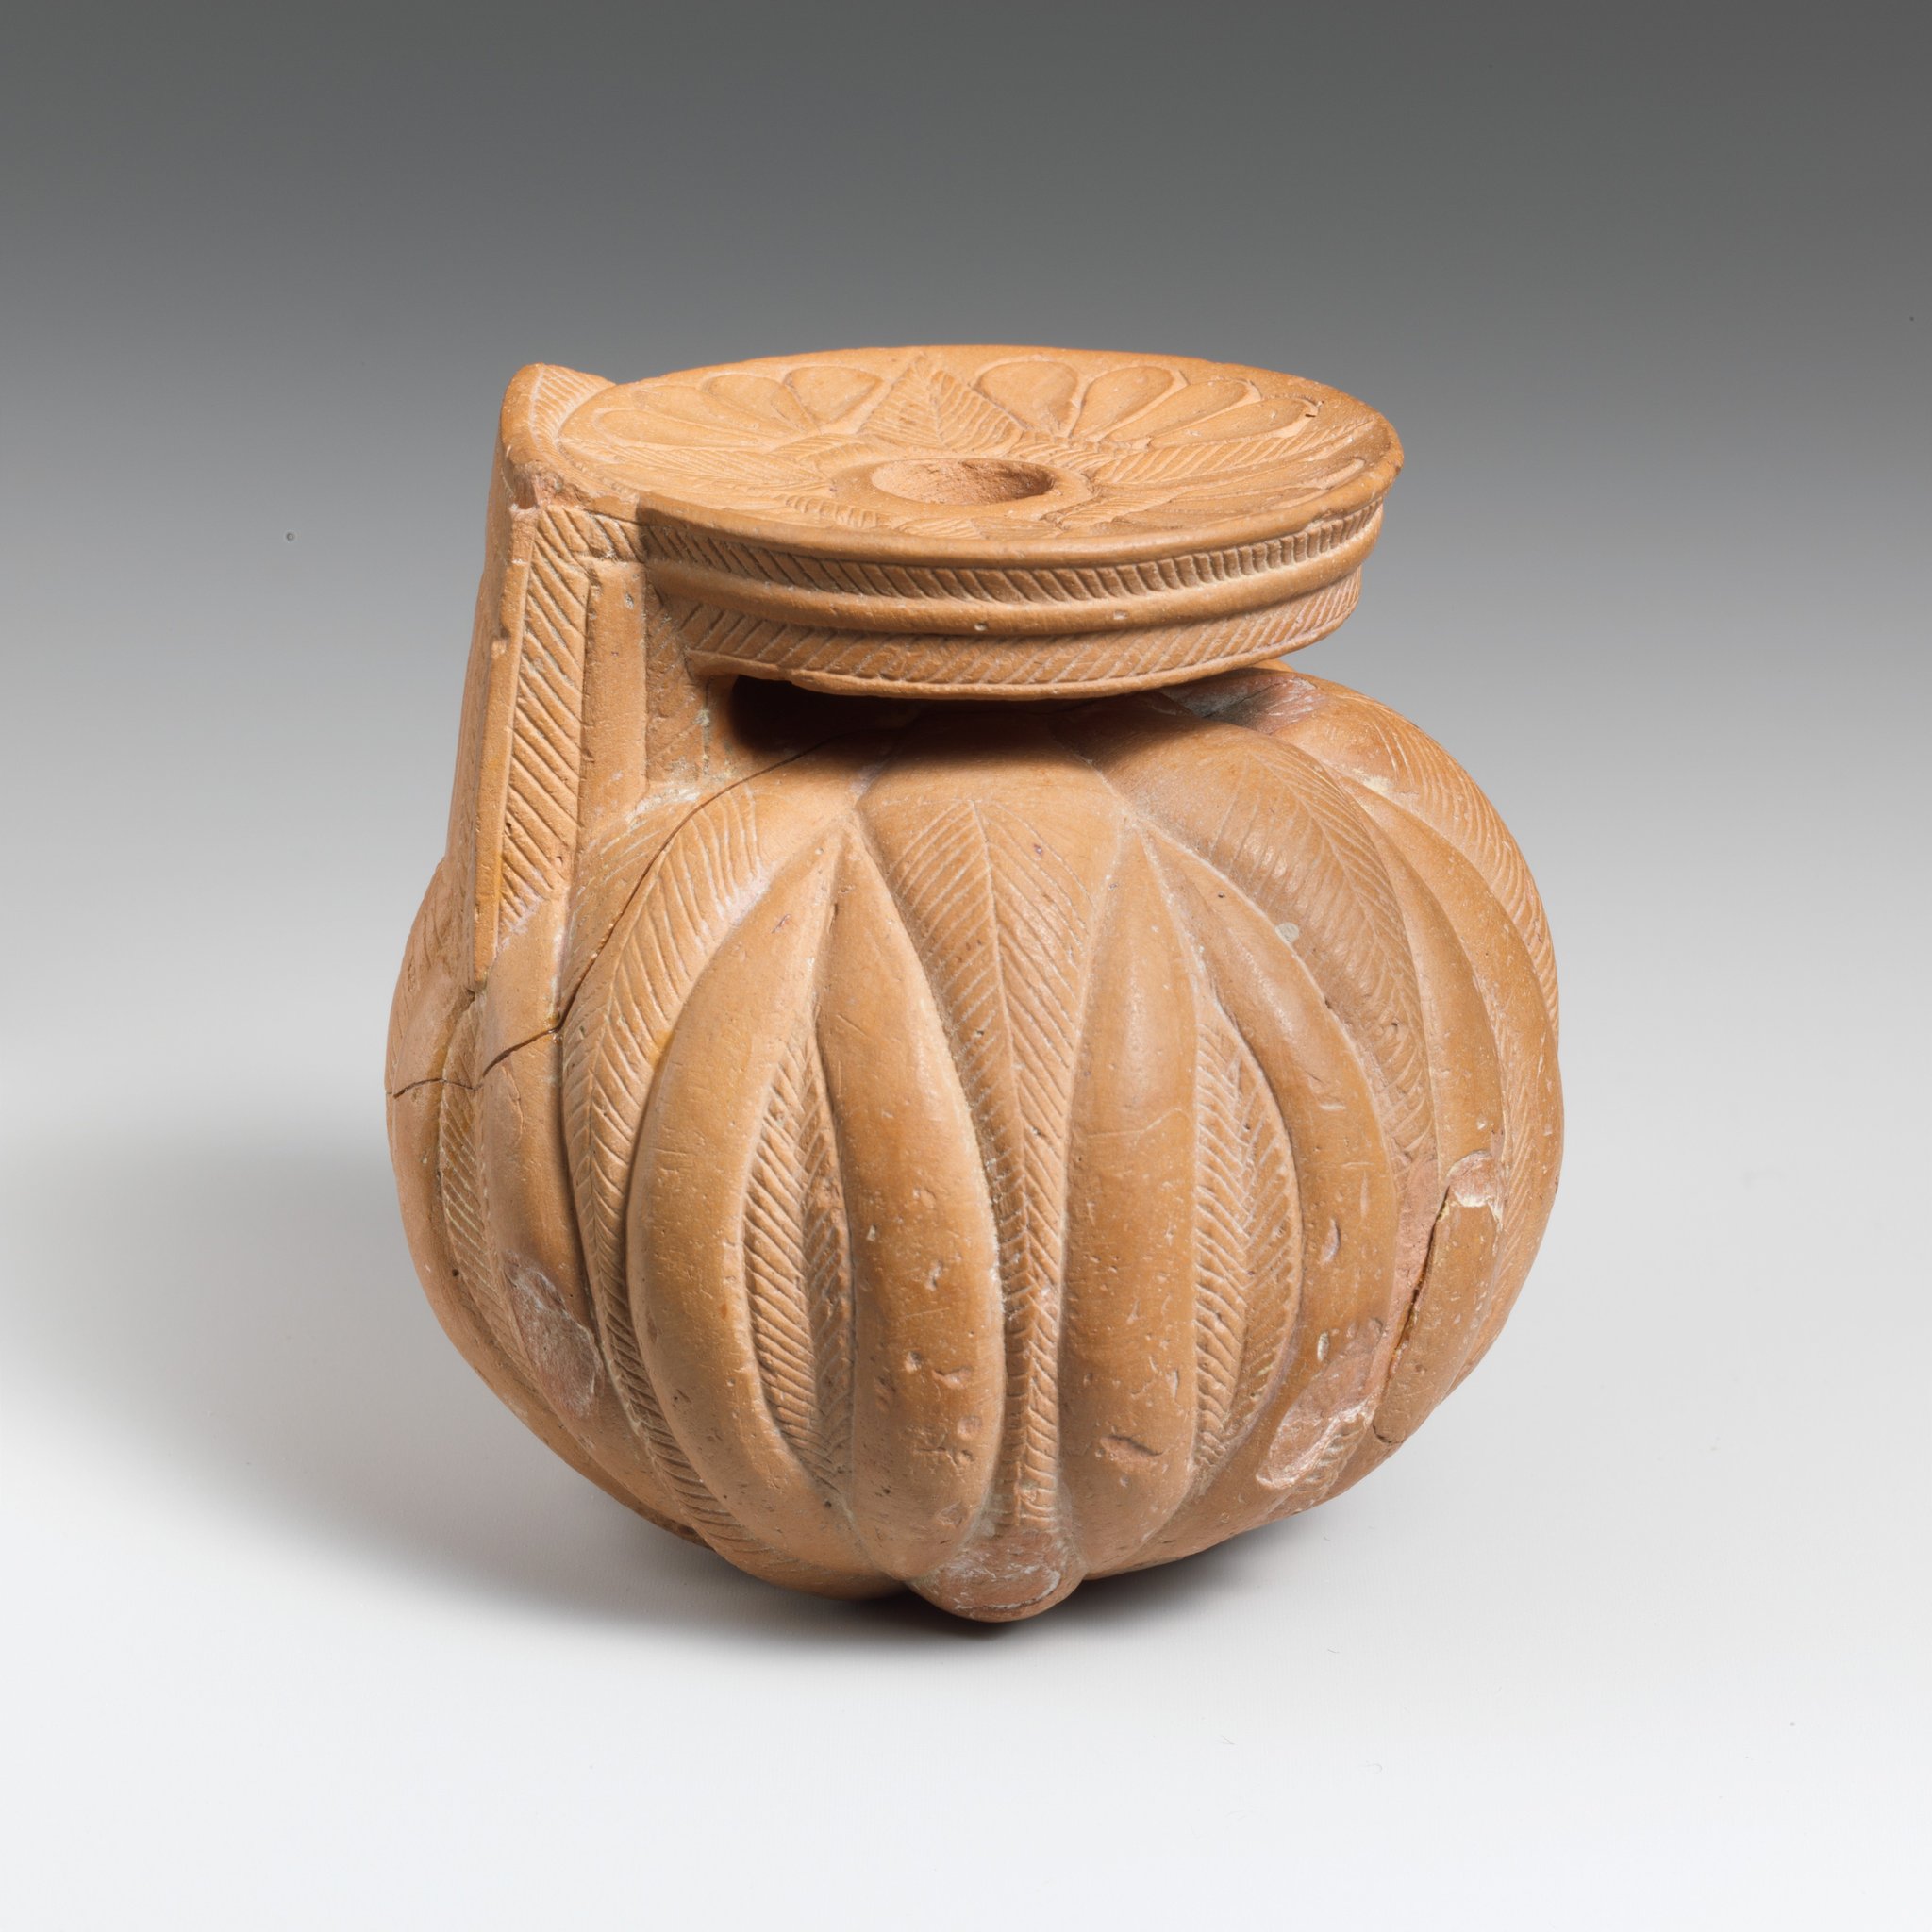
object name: aryballos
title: Terracotta aryballos (oil flask)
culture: east greek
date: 601-700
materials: terracotta